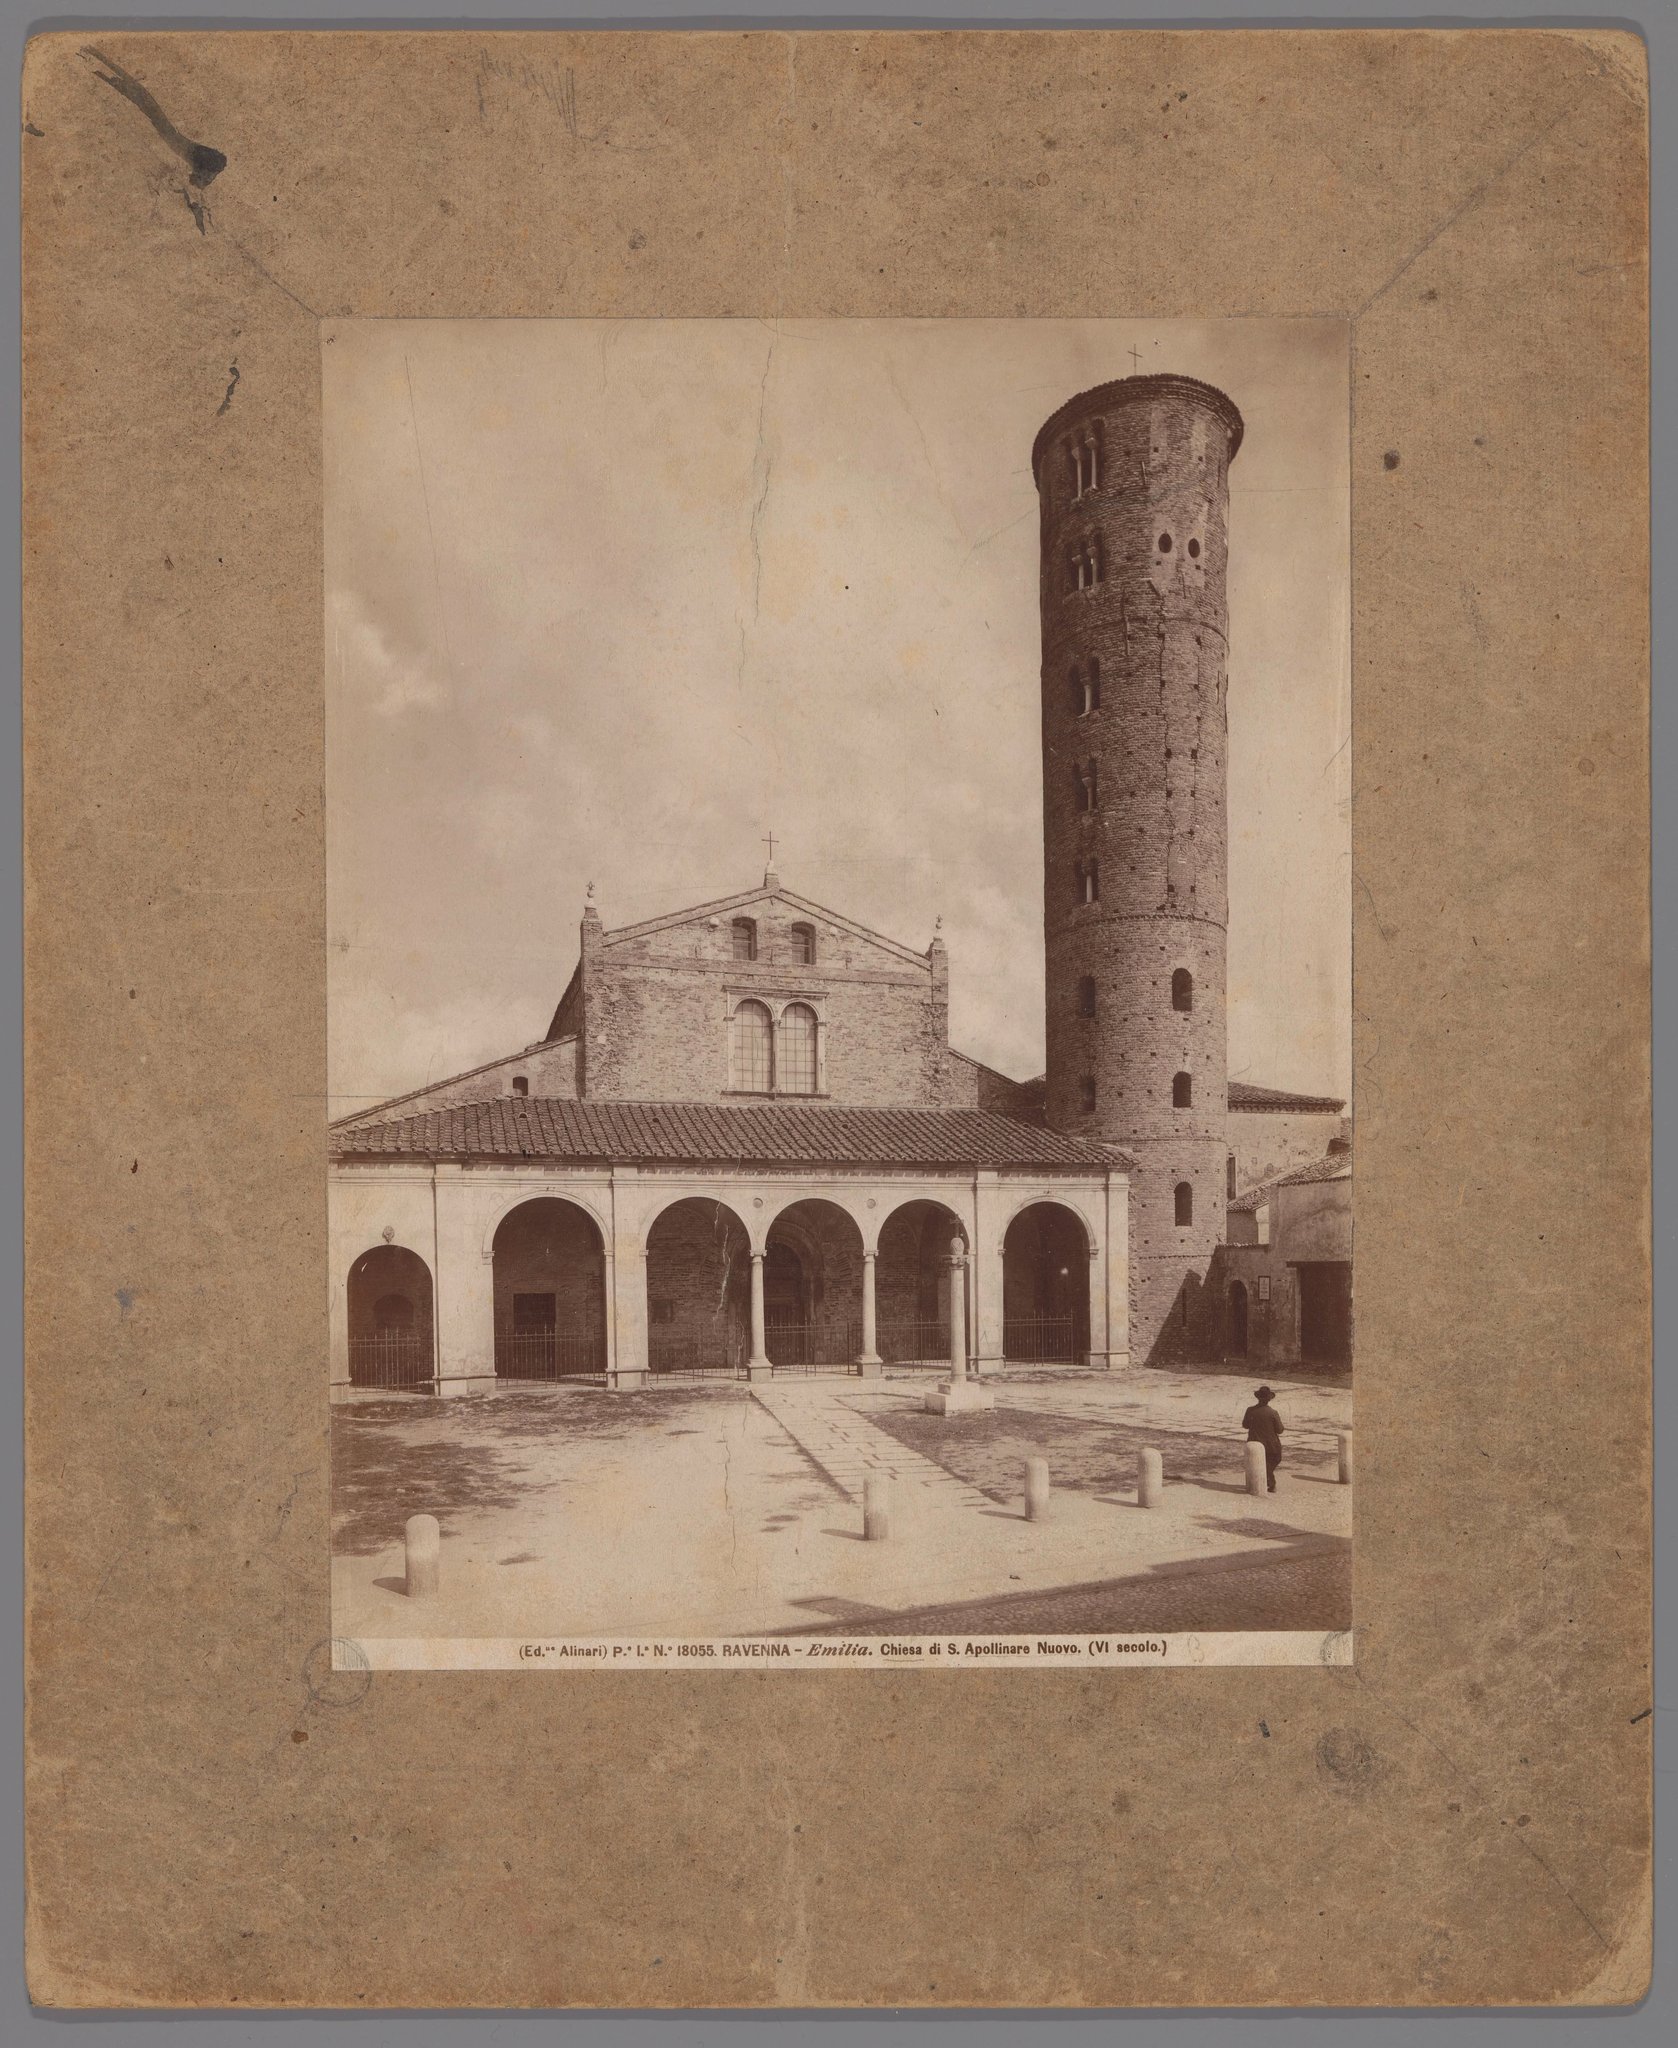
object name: photograph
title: Voorgevel van de Basiliek van Sant'Apollinare Nuovo te Ravenna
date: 1875-1900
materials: cardboard, photographic support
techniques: albumen print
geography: ravenna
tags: tower, clock tower ~ monumental adornment, church (exterior), façade (of house or building)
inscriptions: number: ‘P.e 2.a N.o 18055.’, collector's mark: Lugt 3937, annotation: